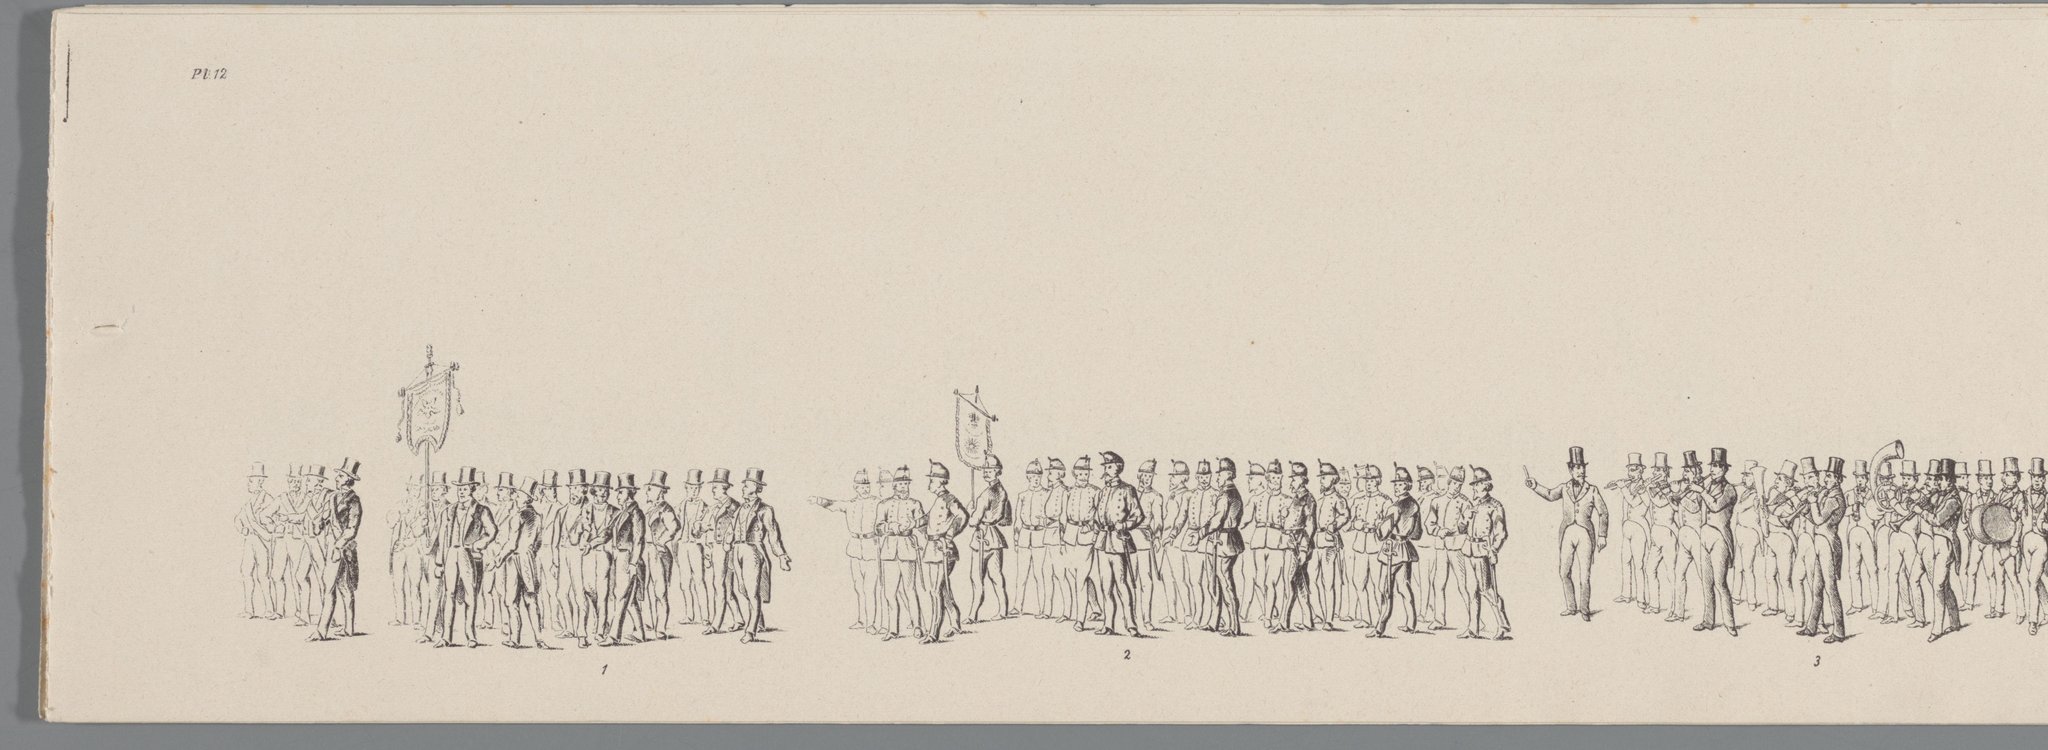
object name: print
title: Historische gekostumeerde optocht te Amsterdam bij het 25-jarige regeringsjubileum van koning Willem III in 1874 (plaat 12)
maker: Anonymous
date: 1874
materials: paper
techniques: lithograph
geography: amsterdam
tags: brussels, willem iii (koning der nederlanden), public festivities at other royal events, not meant or mentioned above (+ parade, pageant, cavalcade ~ festive activities), military music, amsterdam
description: Plaat nr. 12 met het deel van de optocht met twee militaire vereningen en een muziekkorps. Onderdeel van een serie van 24 platen van de gekostumeerde historische en allegorische optocht gehouden te Amsterdam op 12 mei 1874, als onderdeel van de feestelijkheden tijdens de viering van het 25-jarige regeringsjubileum van koning Willem III.